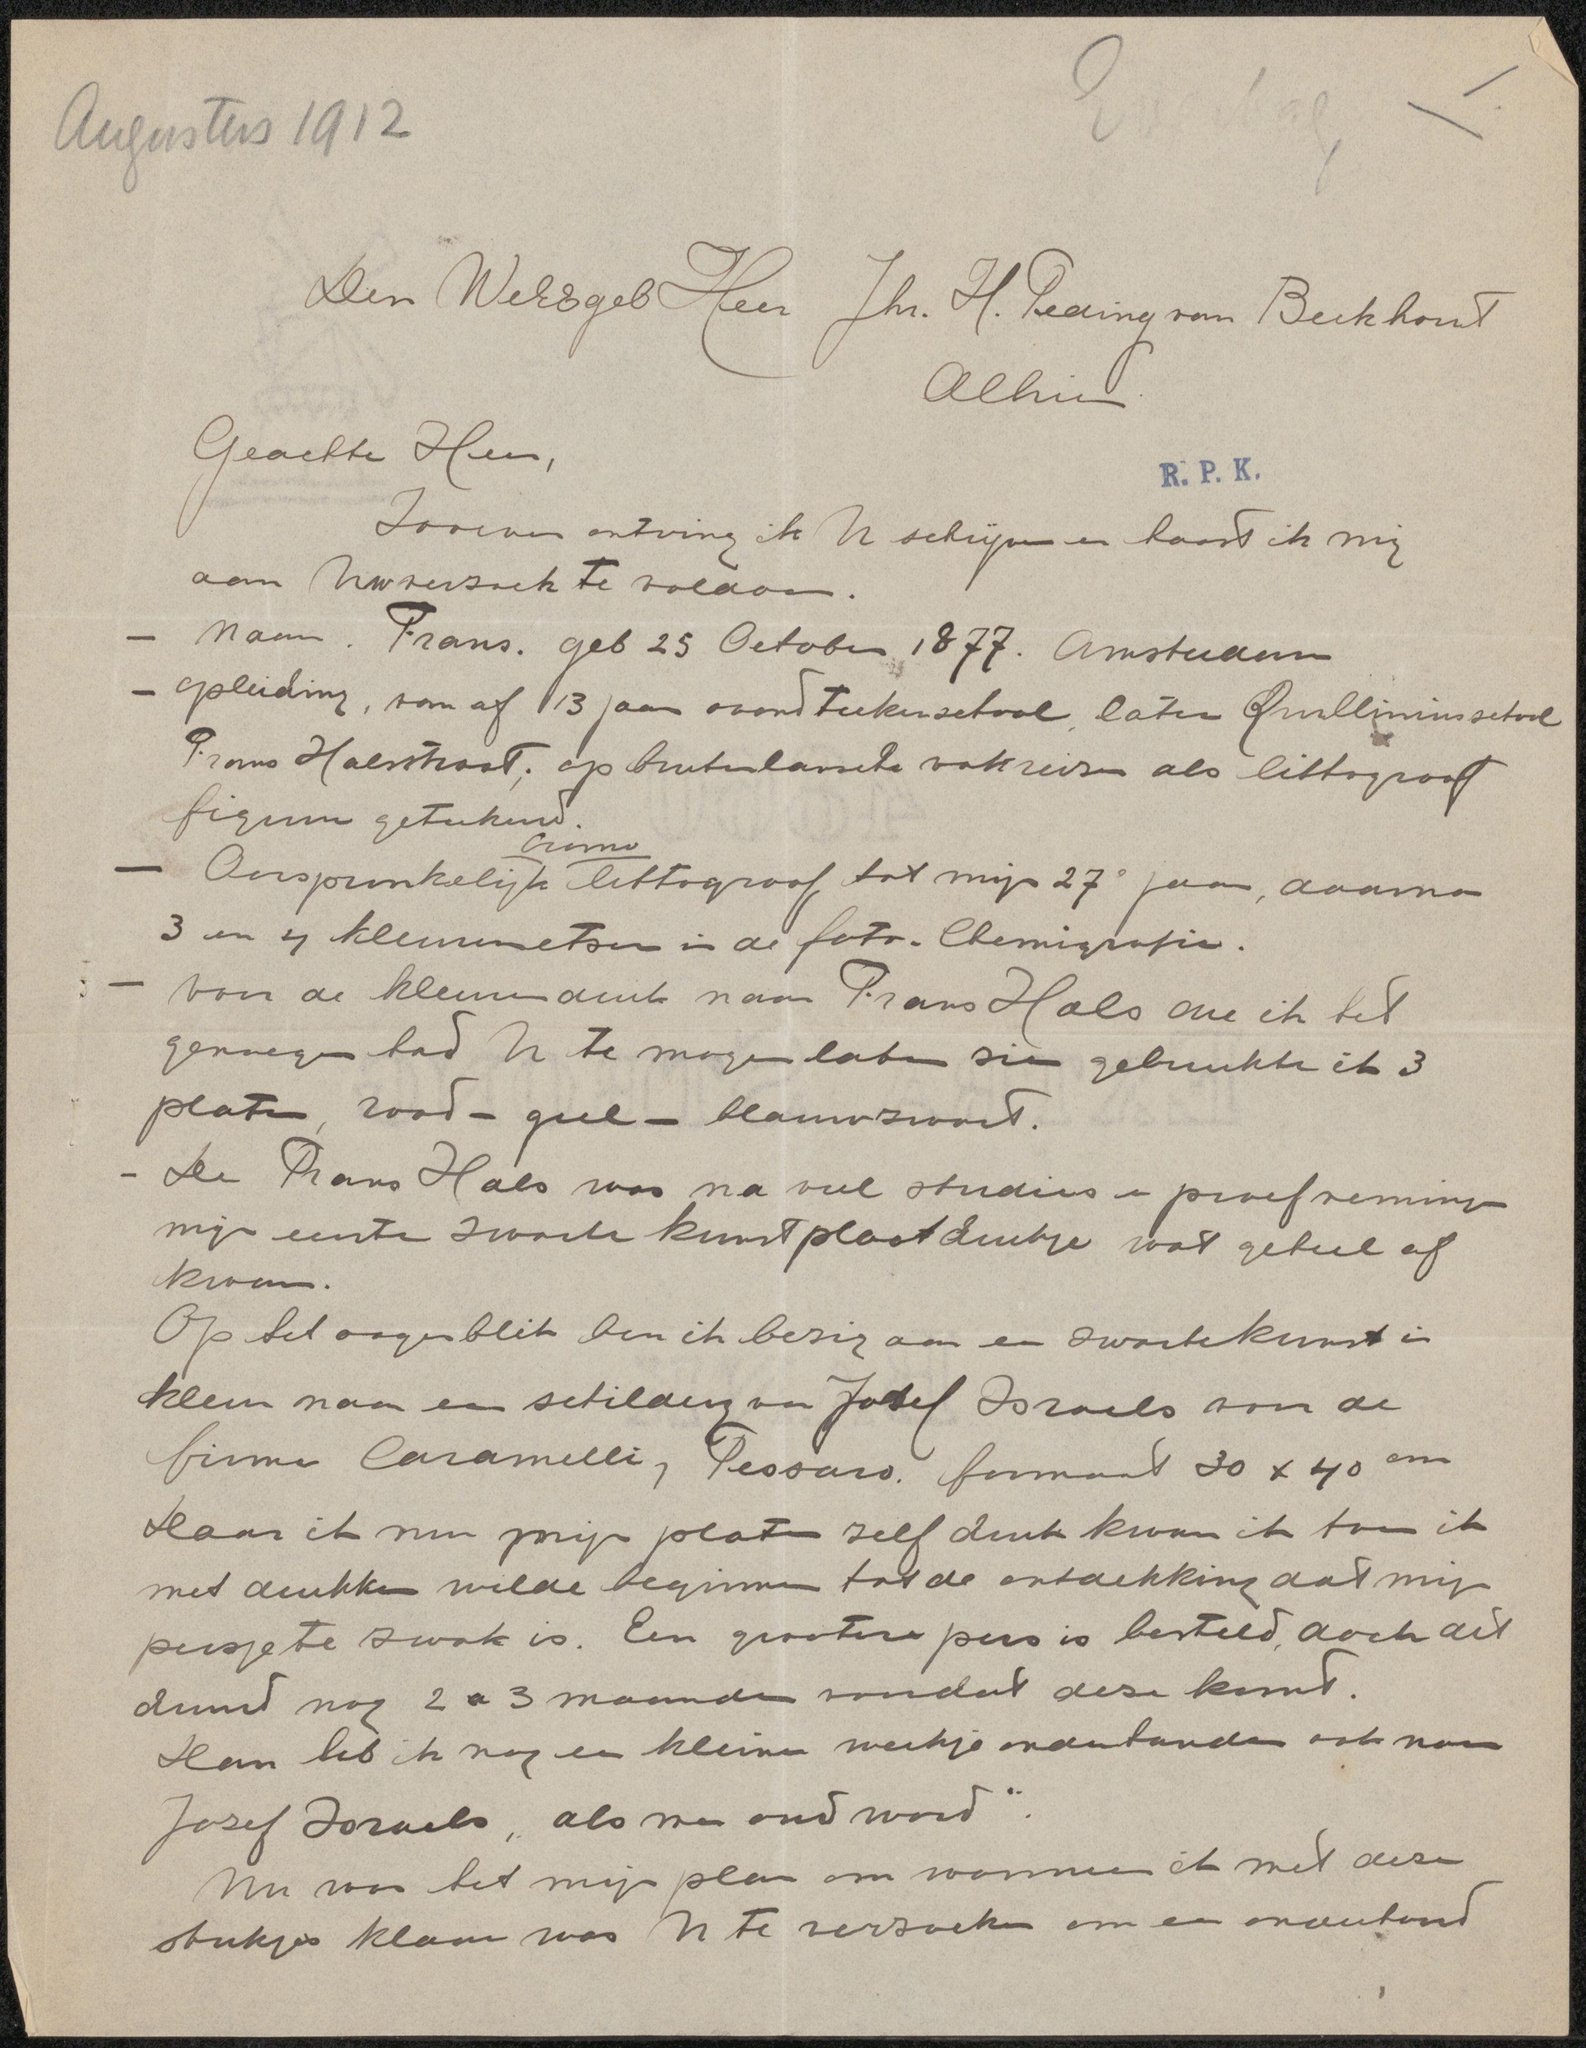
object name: letter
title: Brief aan jonkheer Hendrik Teding van Berkhout (1879-1969)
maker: frans everbag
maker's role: draughtsman, print maker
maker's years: 1877-1947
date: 1912-1934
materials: ink, paper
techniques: pen, writing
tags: painter, print maker, draughtsman, jozef israëls, antwerp, frans hals, haarlem, amsterdam, jonkheer hendrik teding van berkhout (1879-1969), the graphic arts, education, tuition of the artist (in general)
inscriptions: watermark, collector's mark: Lugt 2233